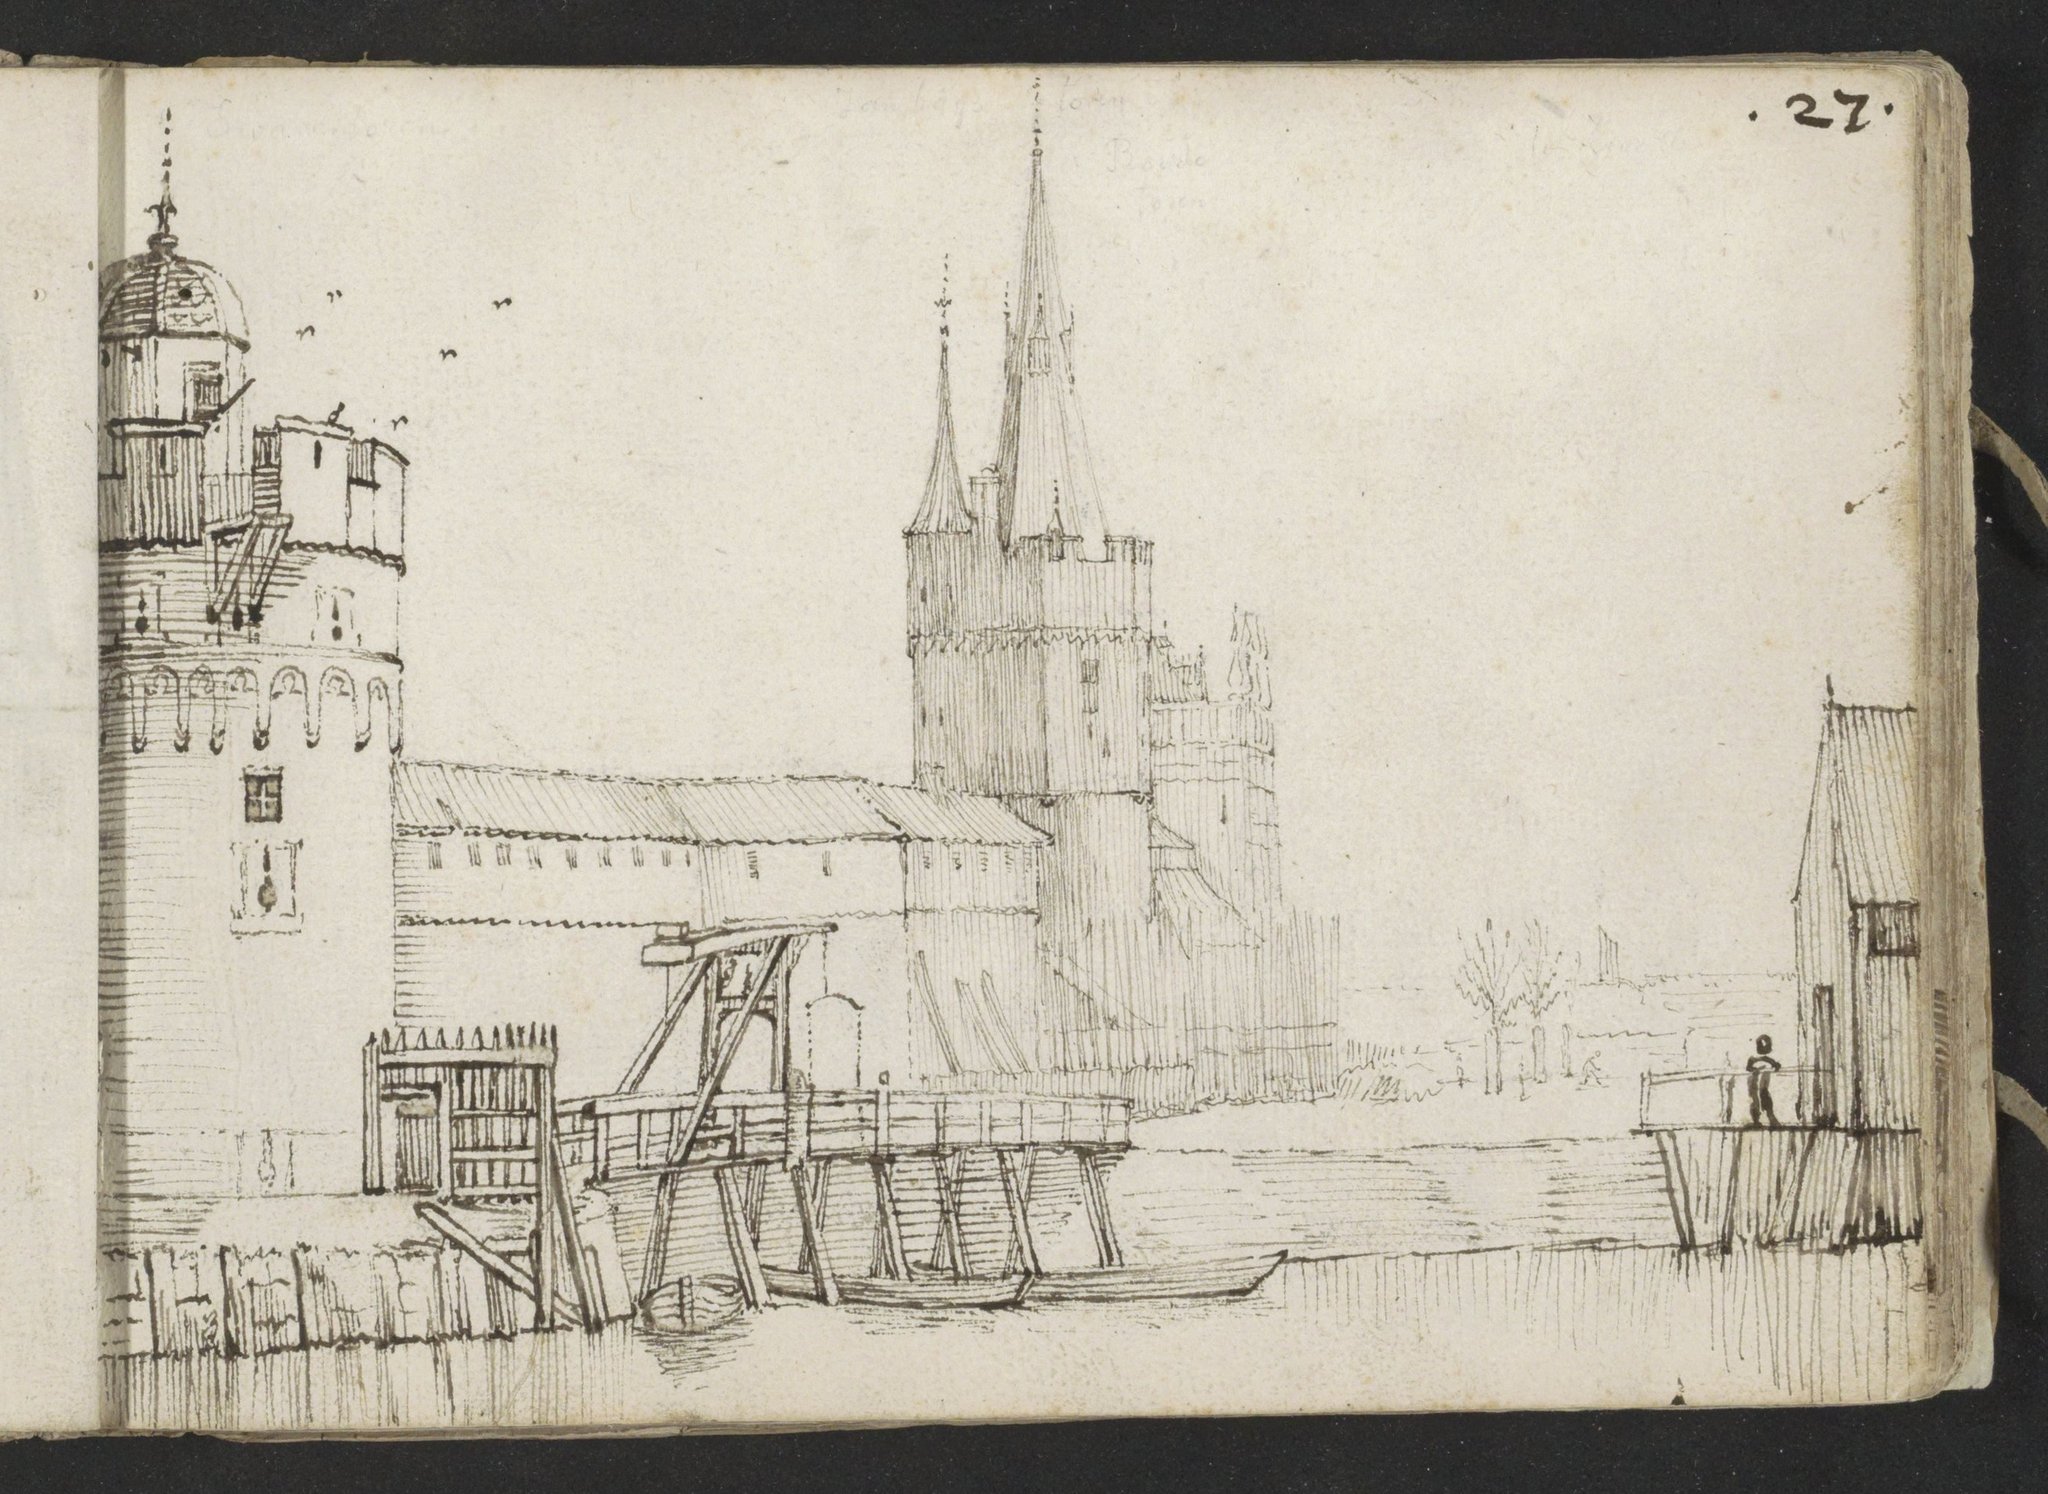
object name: sketchbook leaf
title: Gezicht op Zwolle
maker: gerard ter borch (ii)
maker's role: draughtsman, painter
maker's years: 1617-1681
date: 1631-1633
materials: ink, paper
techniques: pen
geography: zwolle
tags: city-view, and landscape with man-made constructions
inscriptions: annotation: ‘Swanentoren, Janbagstoren, Roodetoren te Zwolle’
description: Gezicht op de Zwanentoren, de brug over de Kleine Aa, de Jan Baghstoren en Rode Toren. Blad 27 recto uit een schetsboek met 55 bladen.